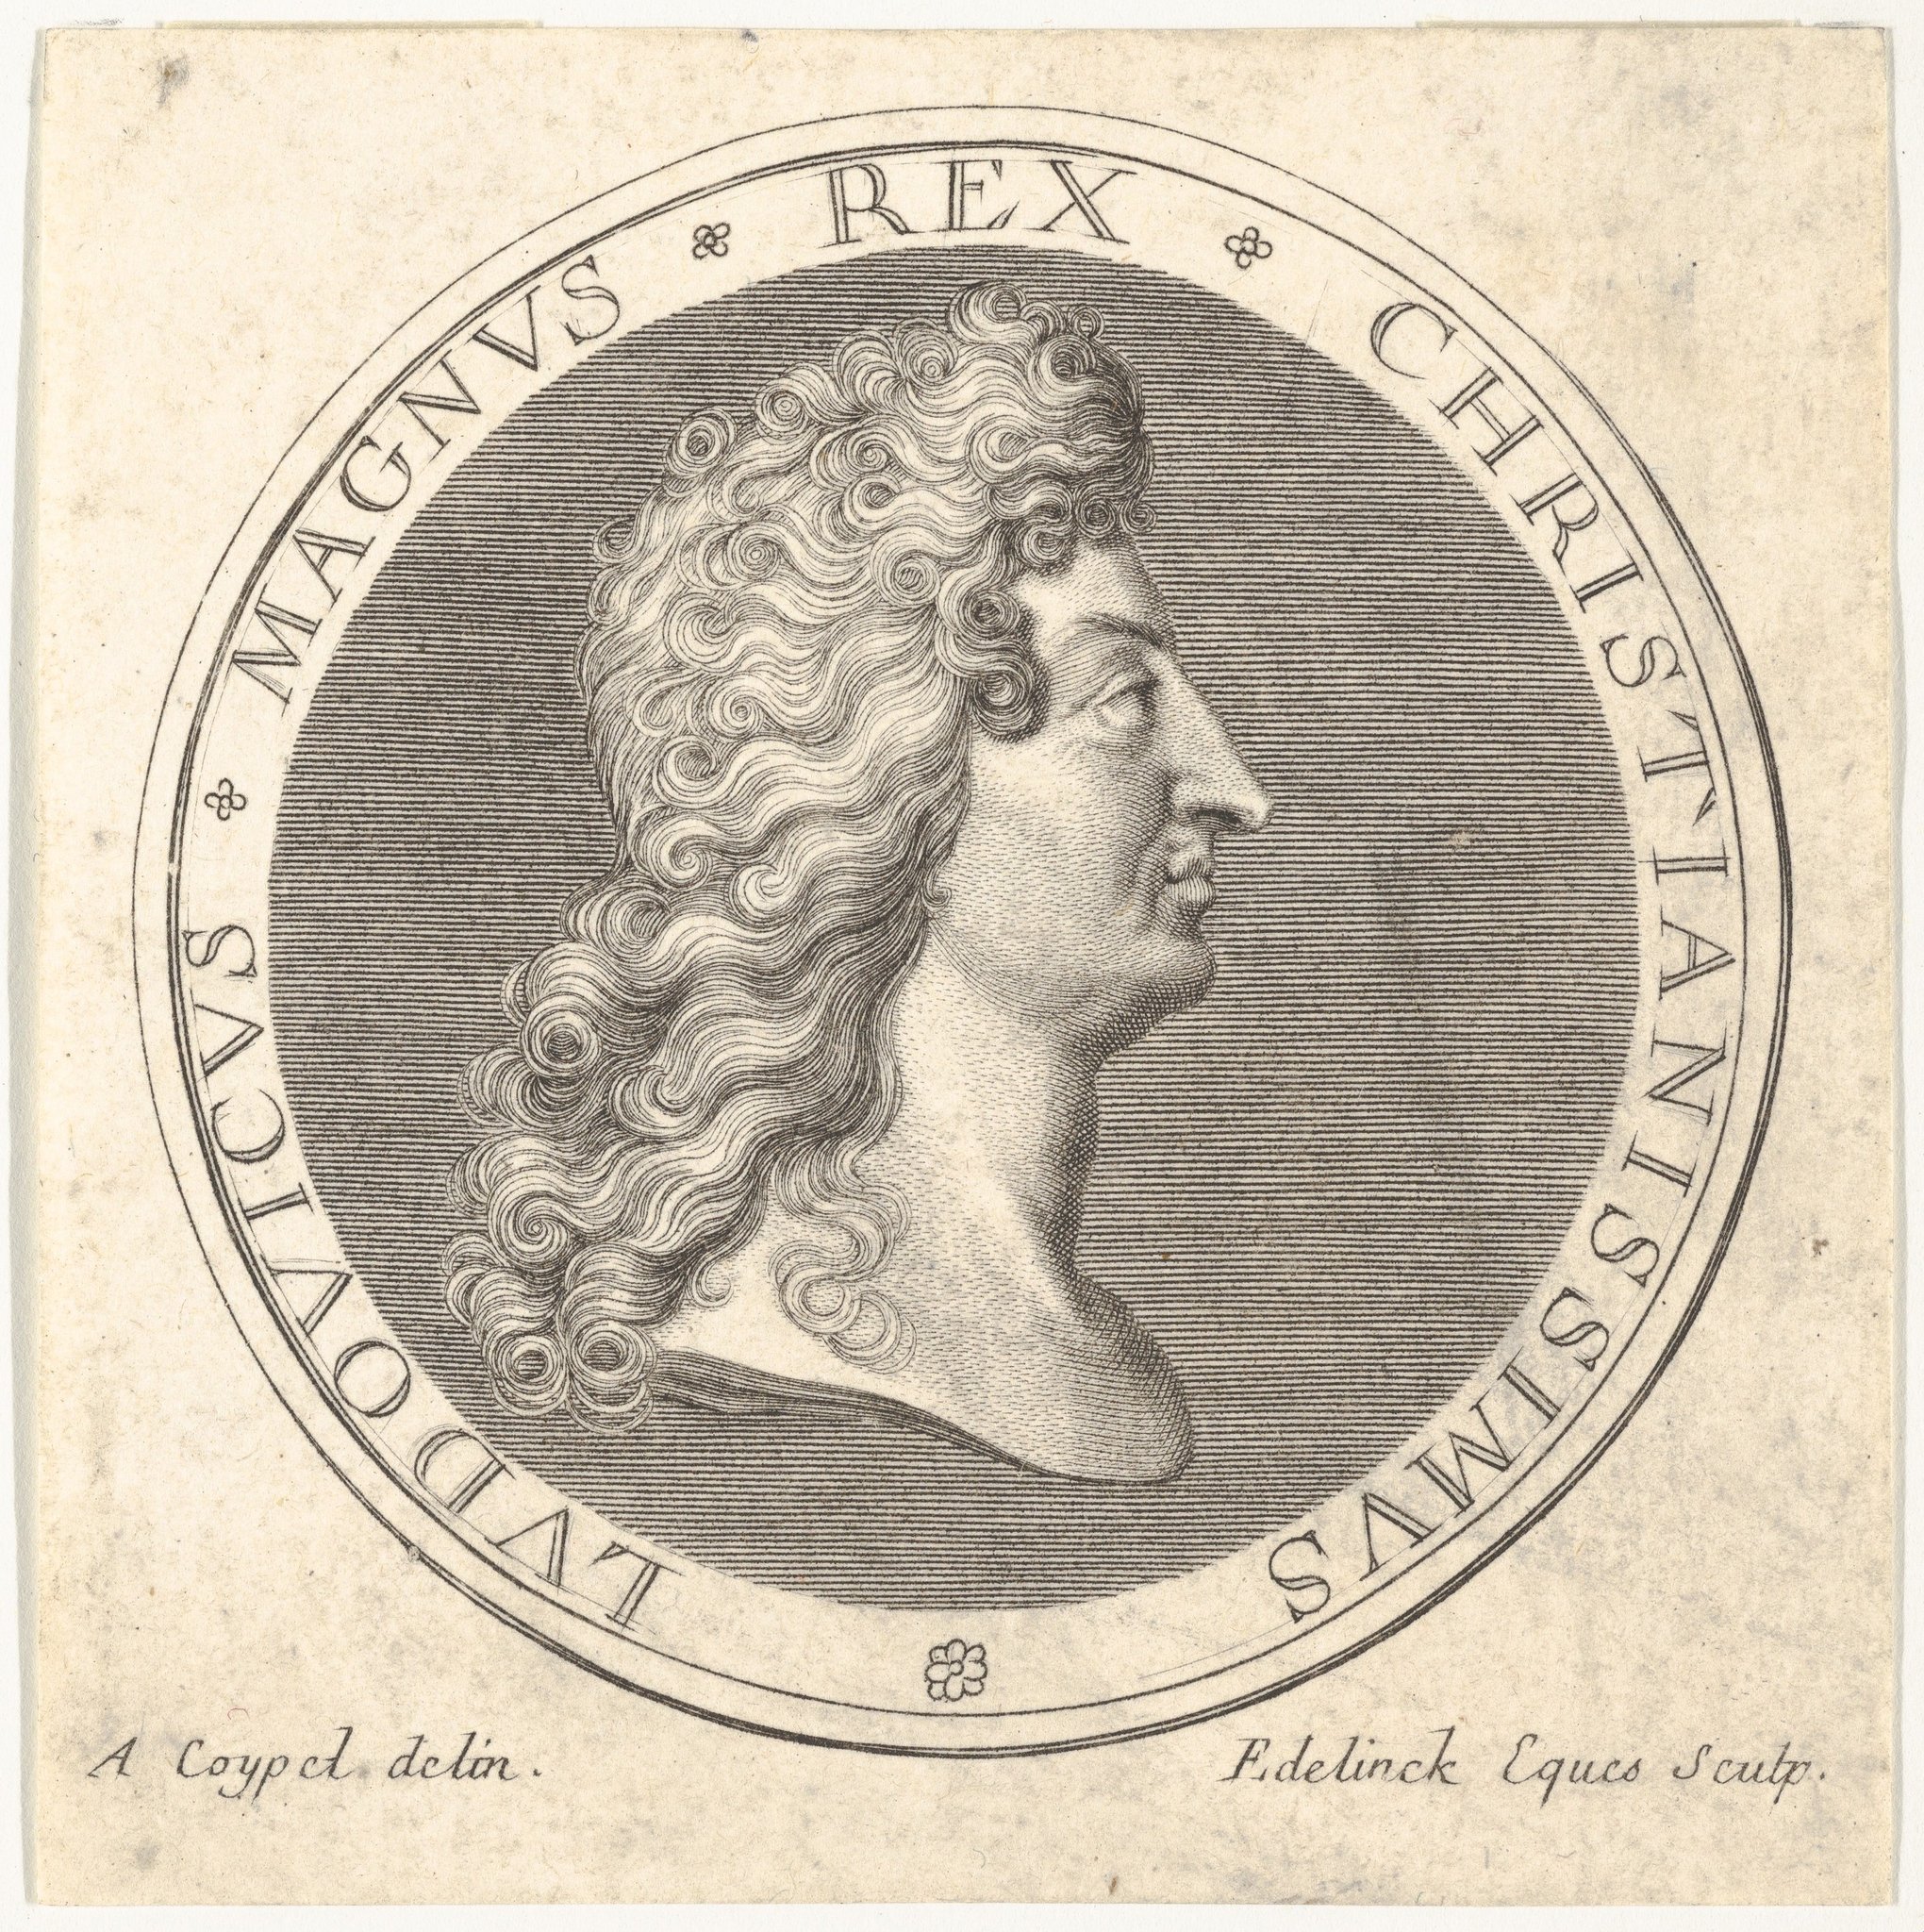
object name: print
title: Medal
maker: gerard edelinck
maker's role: artist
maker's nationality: dutch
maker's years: 1640-1707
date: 1601-1800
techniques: engraving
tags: men,profiles